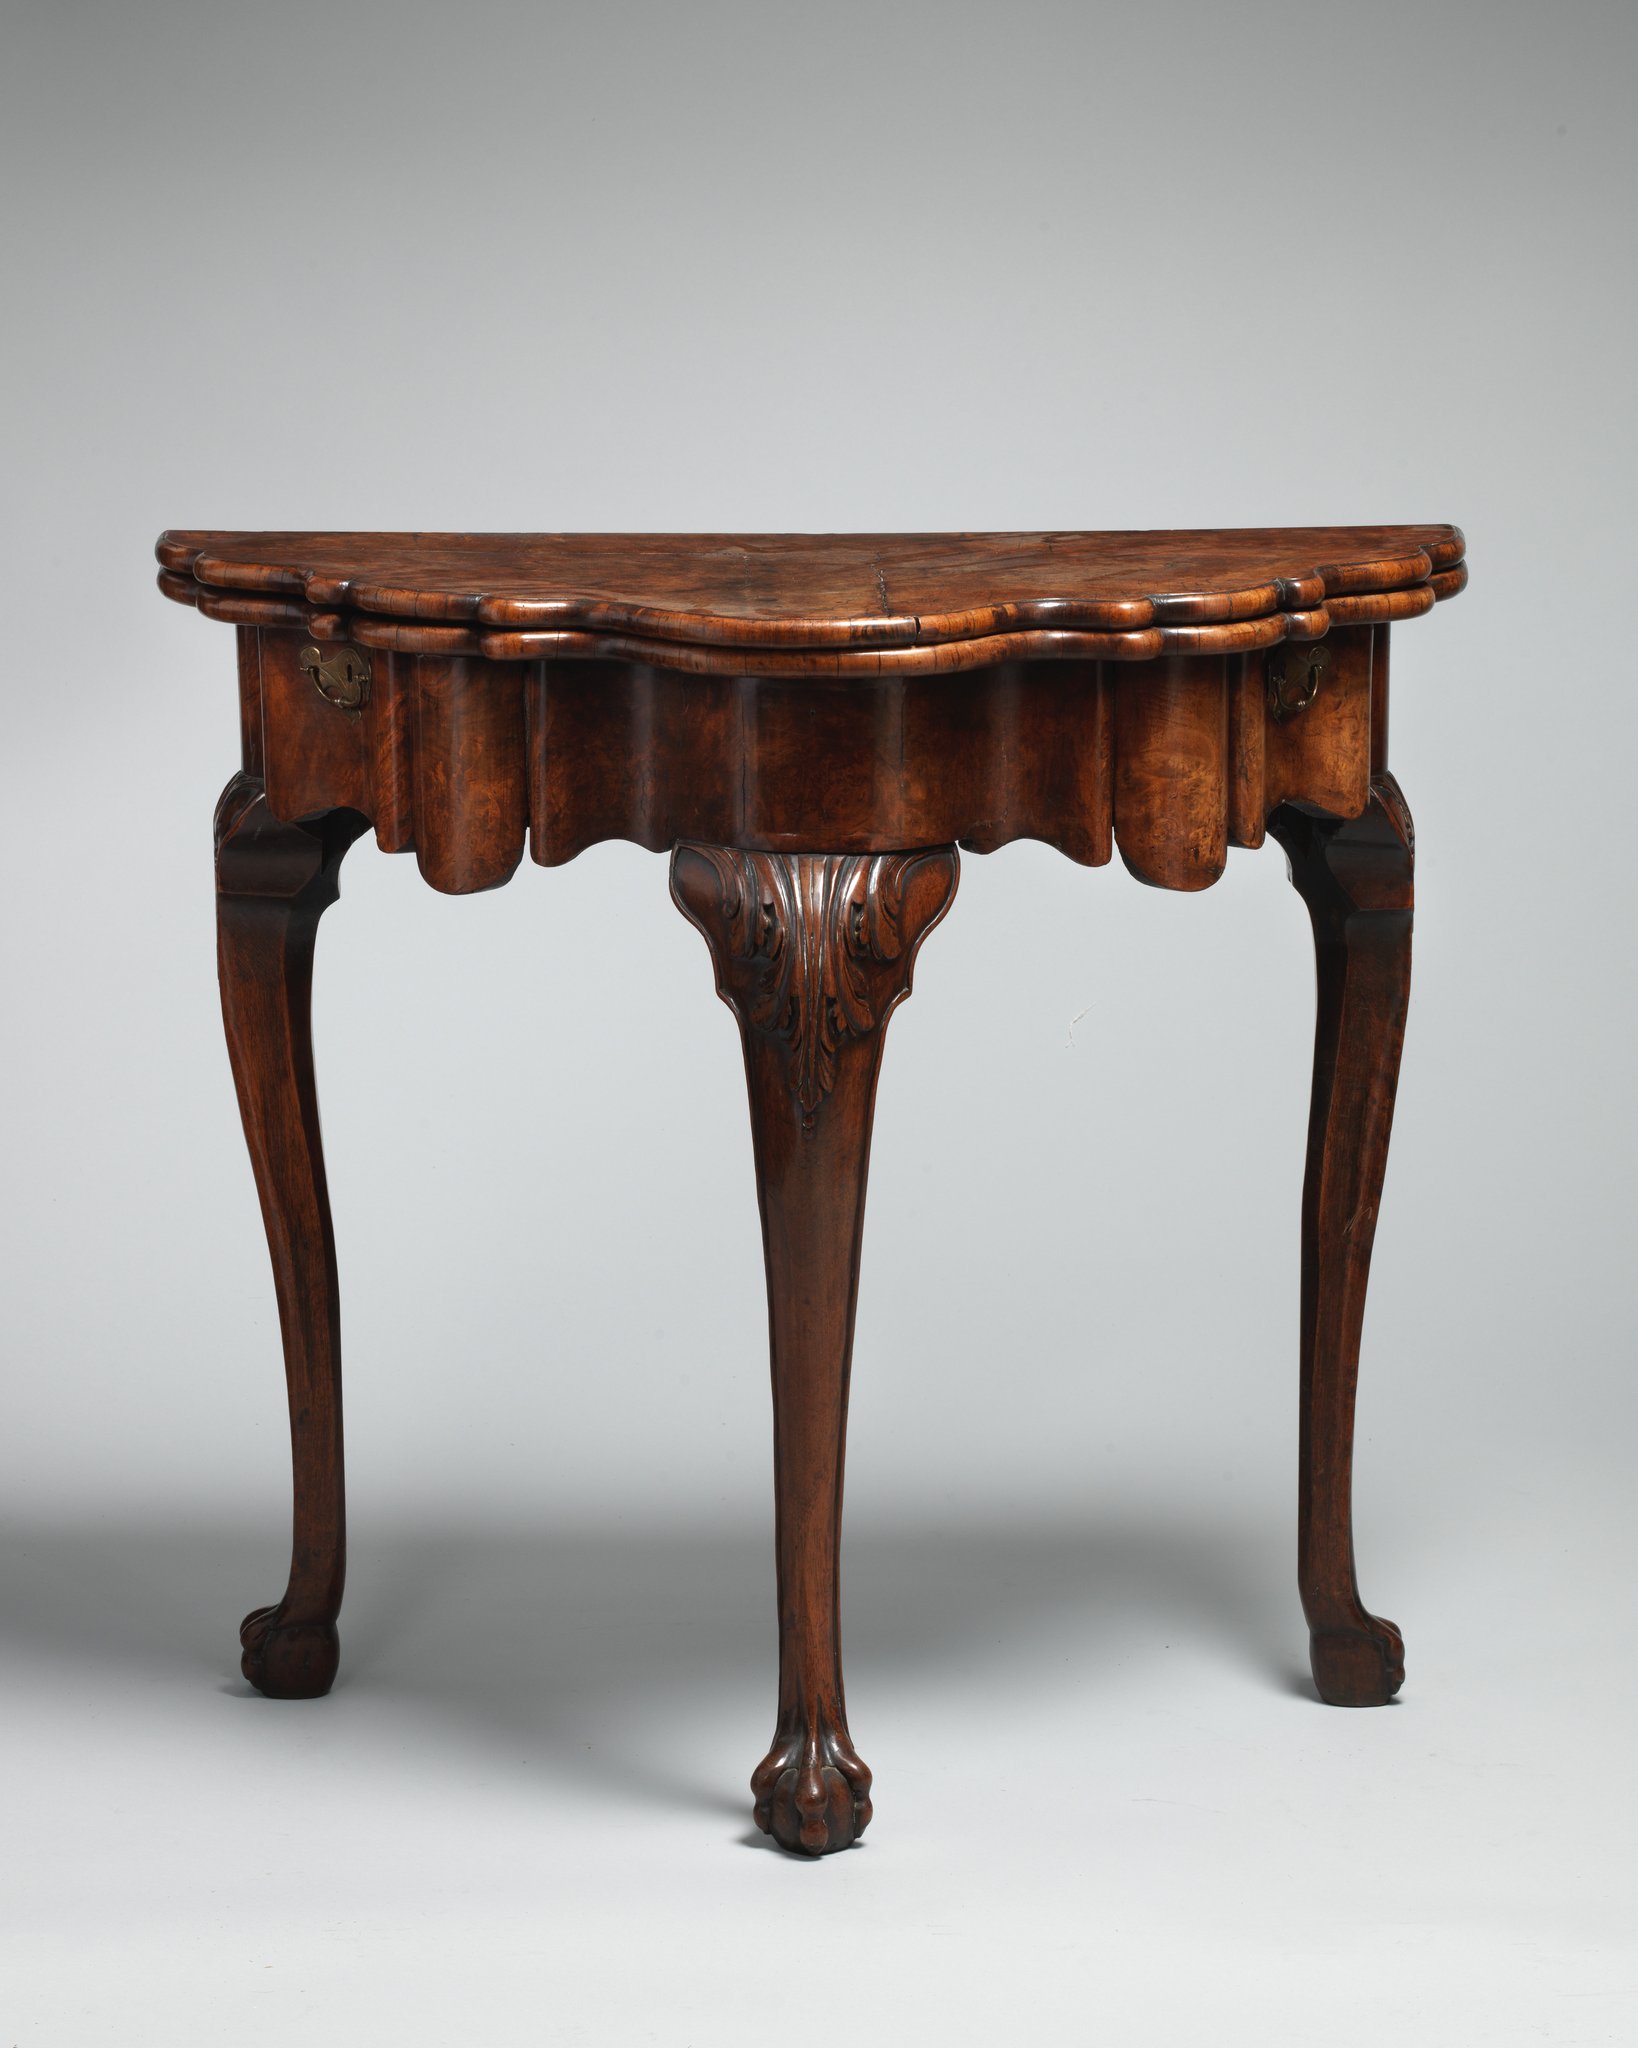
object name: card table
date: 1725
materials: brass, wood